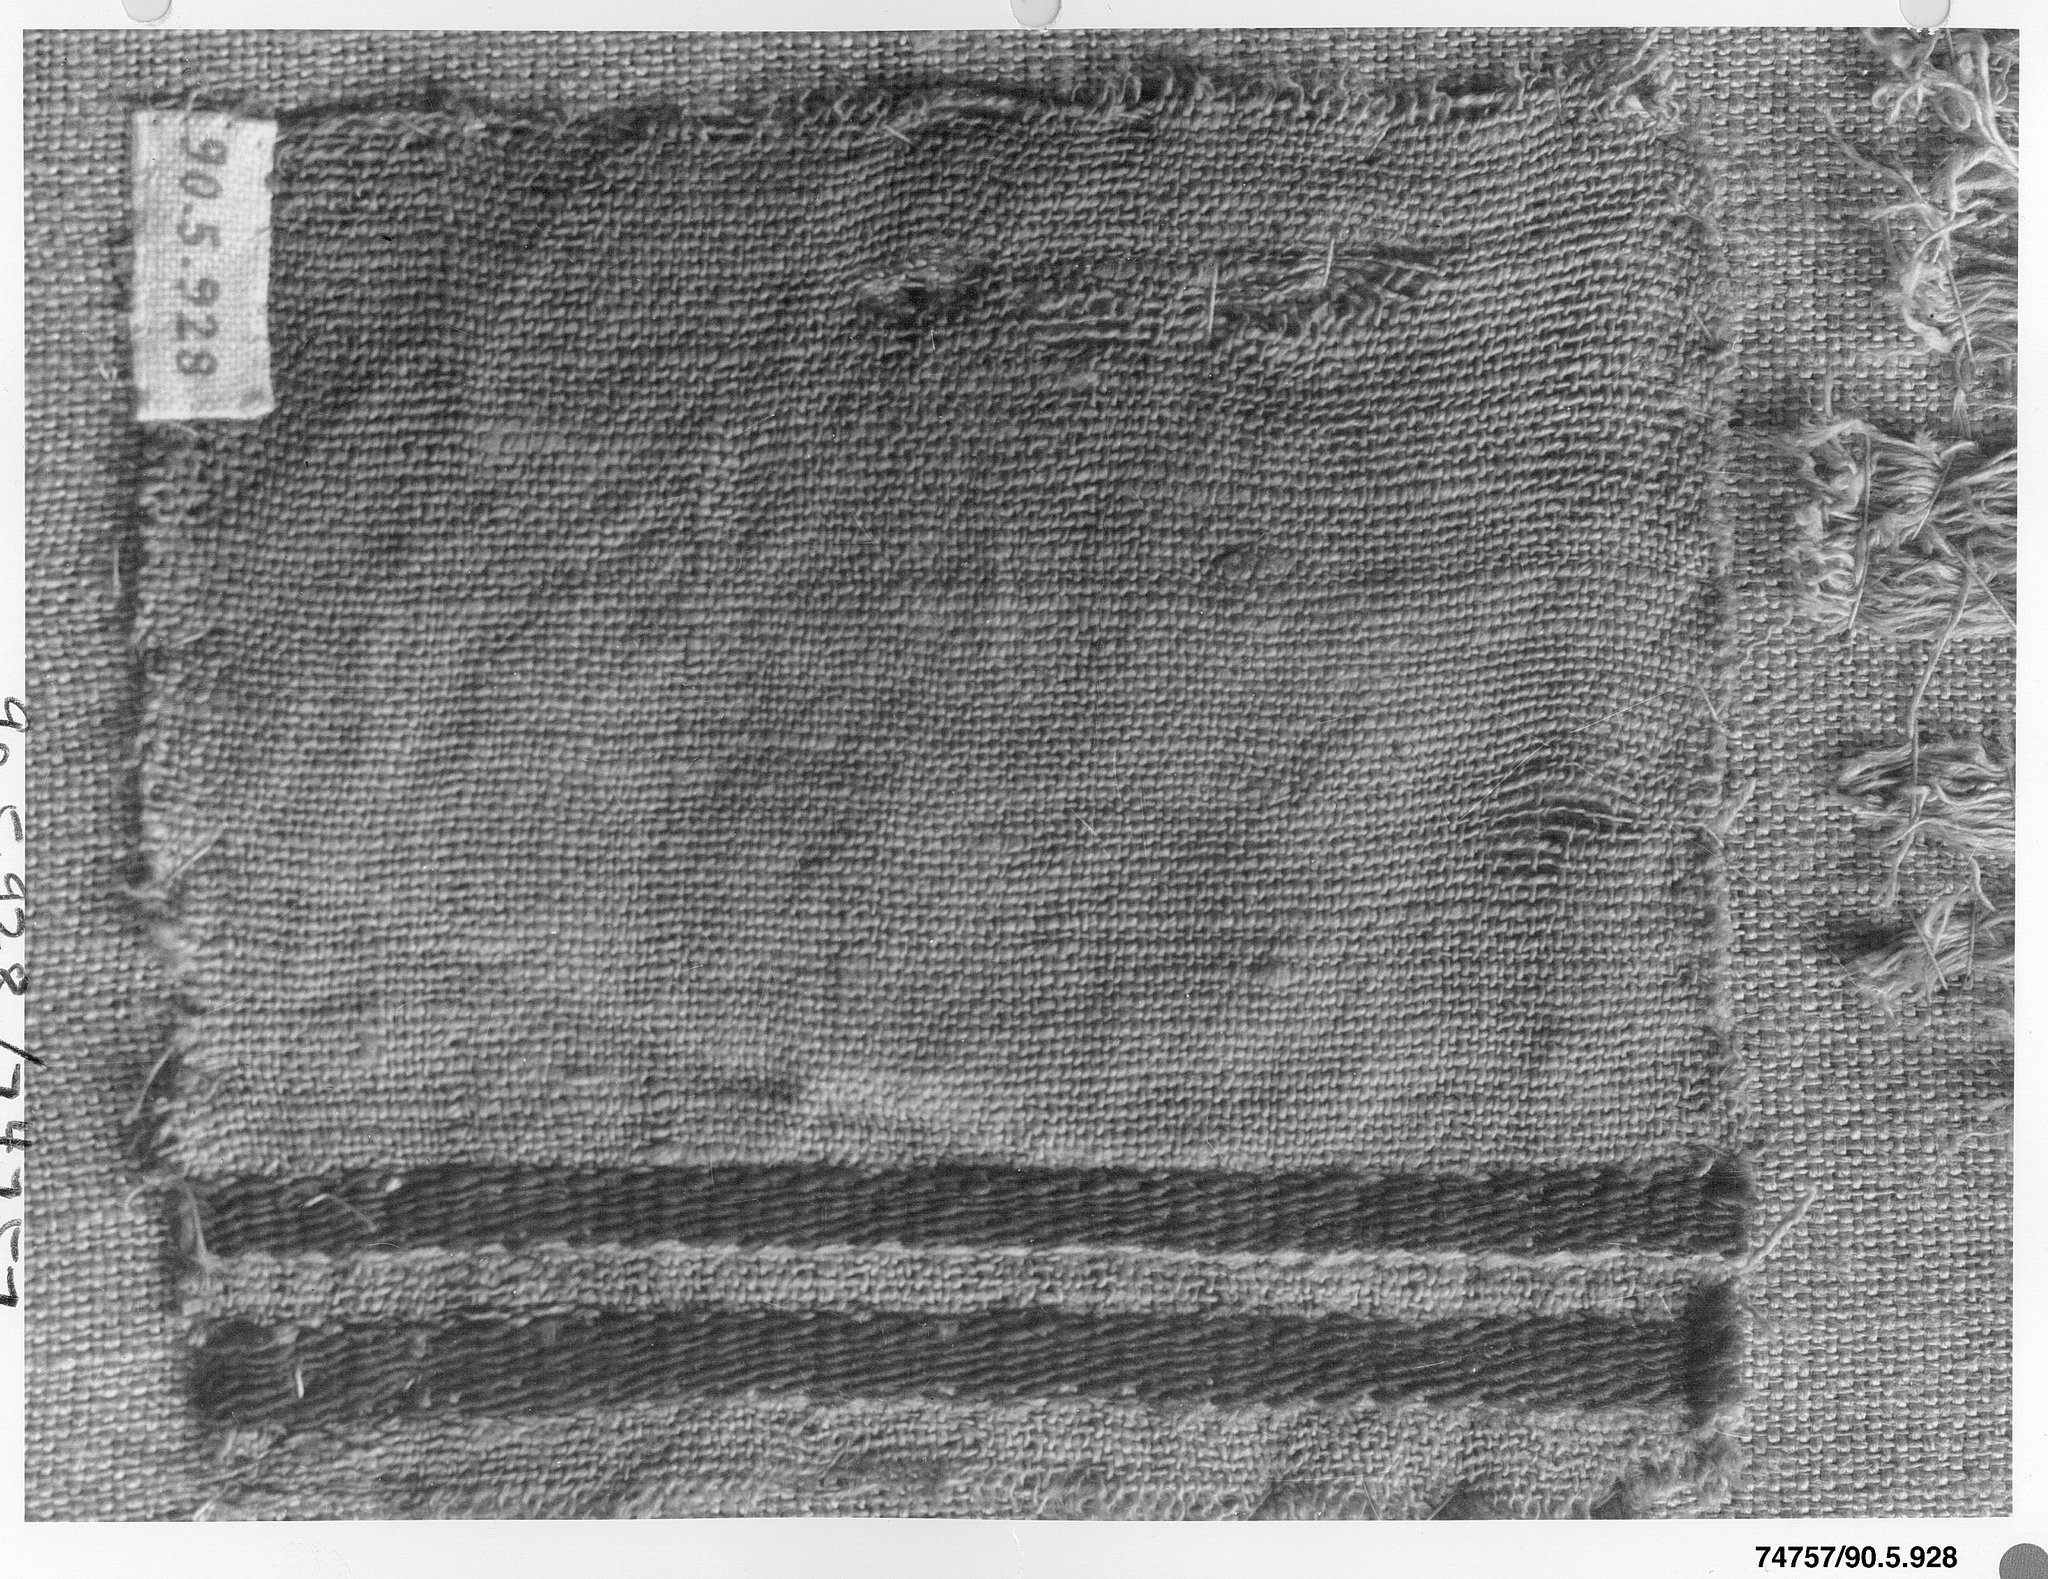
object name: textile fragment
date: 101-300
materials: linen, wool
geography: egypt